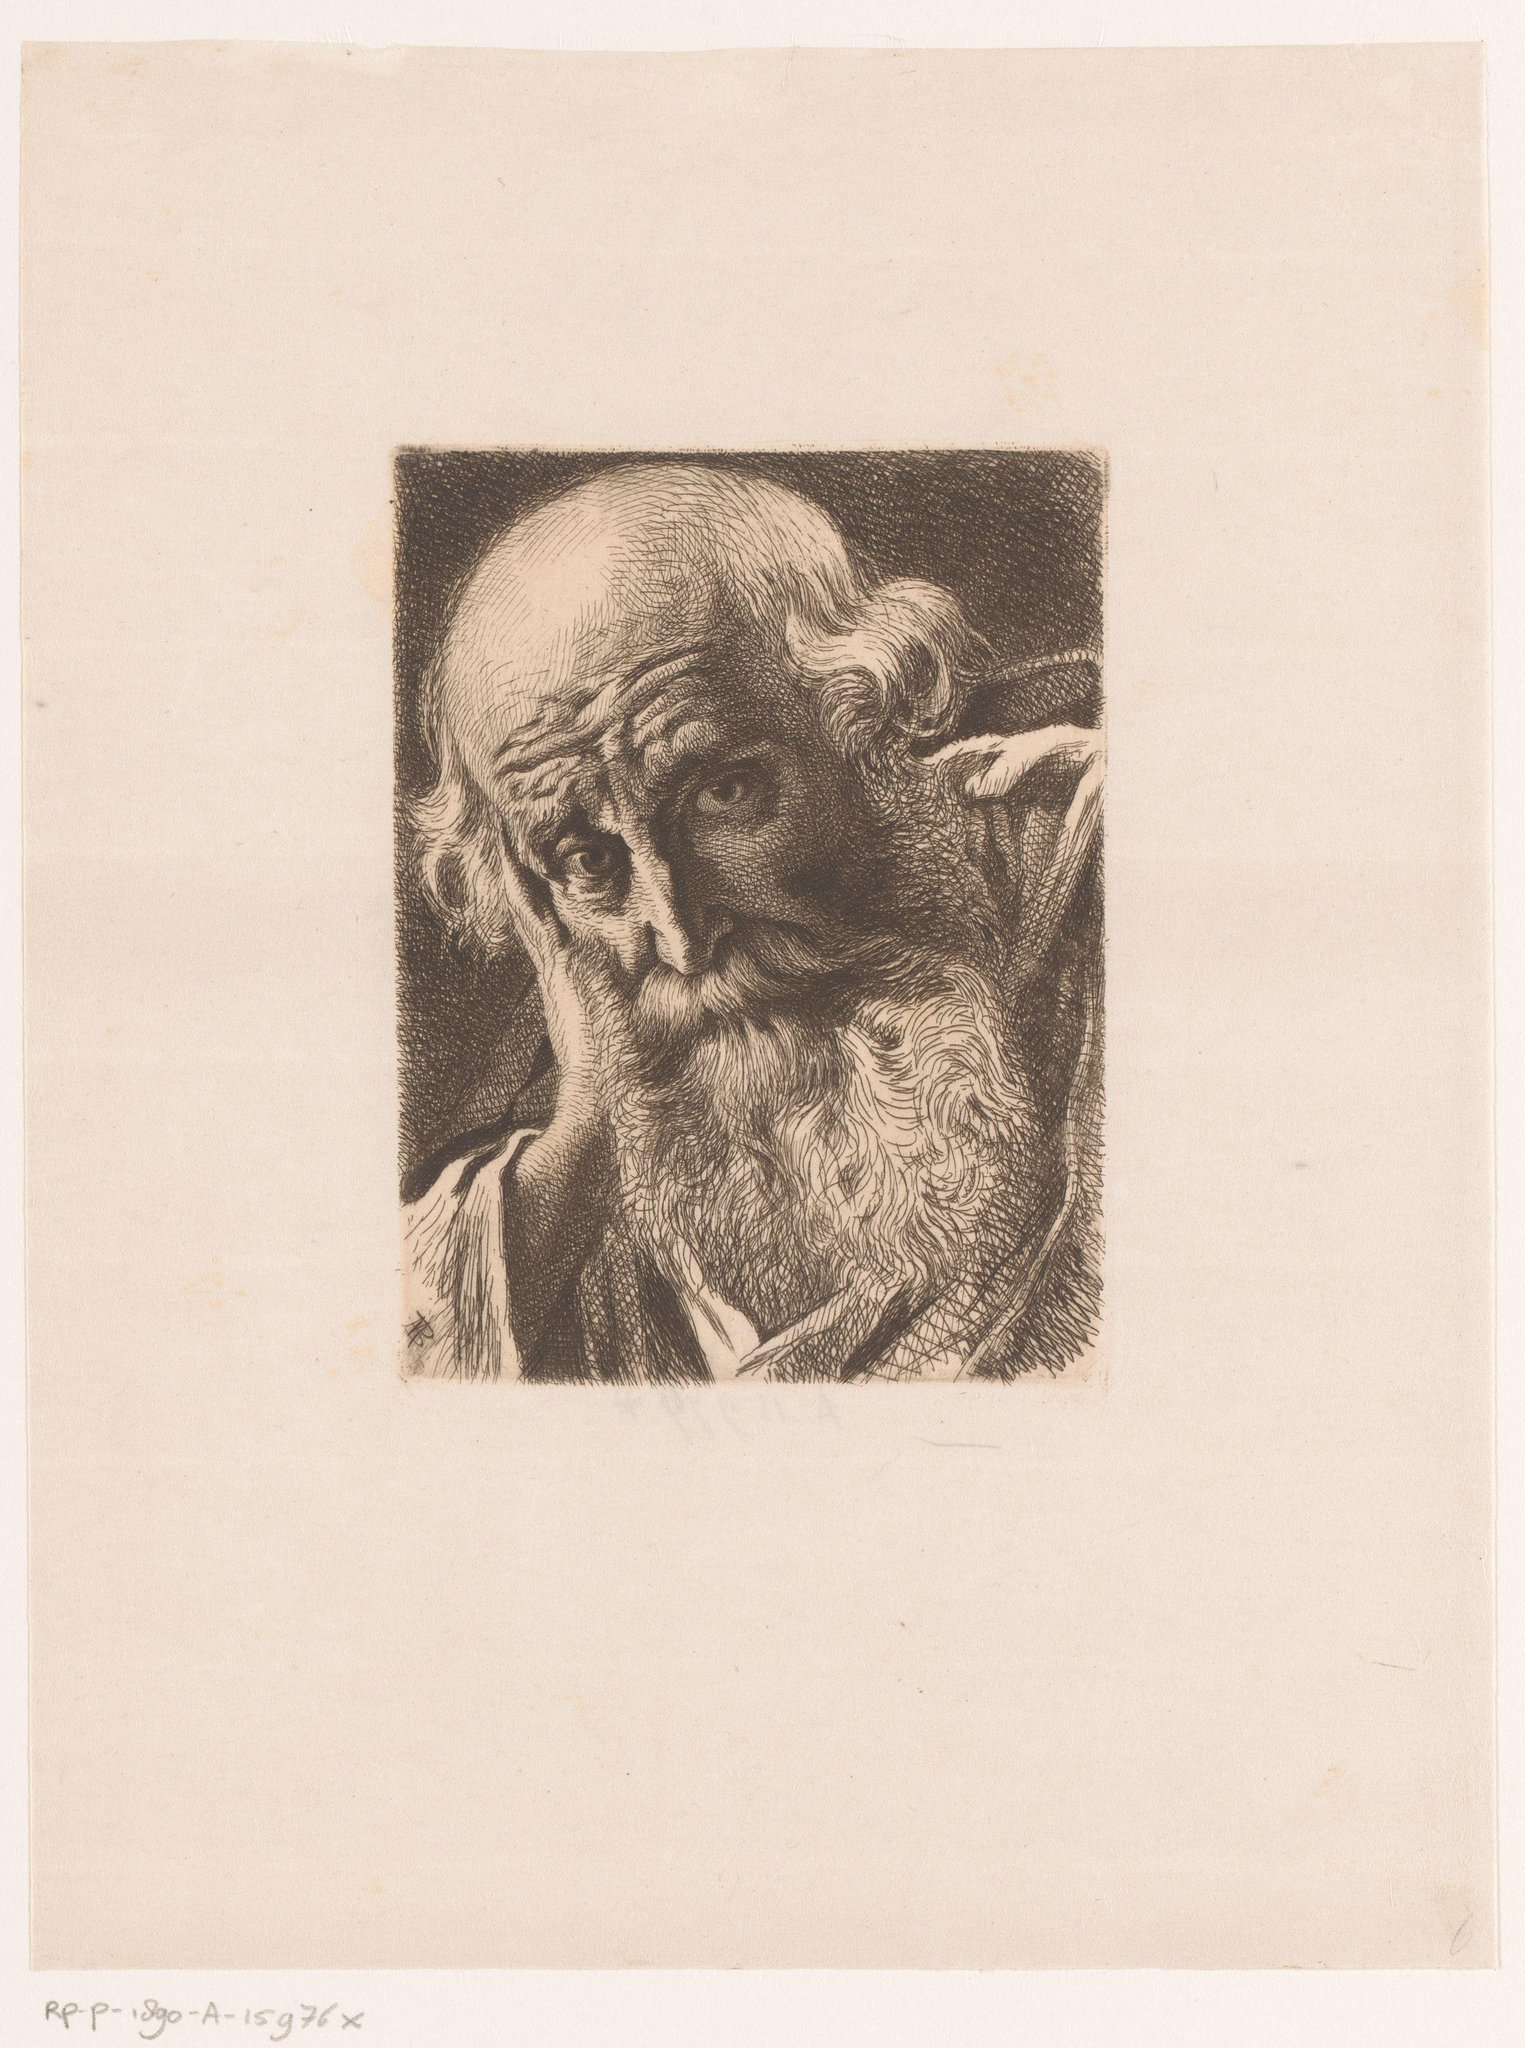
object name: print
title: Hoofd van een oude man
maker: jean baptiste pierre michiels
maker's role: print maker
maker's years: 1821-1890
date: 1880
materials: paper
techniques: etching, intaglio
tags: old man, beard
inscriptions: collector's mark: Lugt 2228, mark: ‘Antwerpsche Etsers 1880’